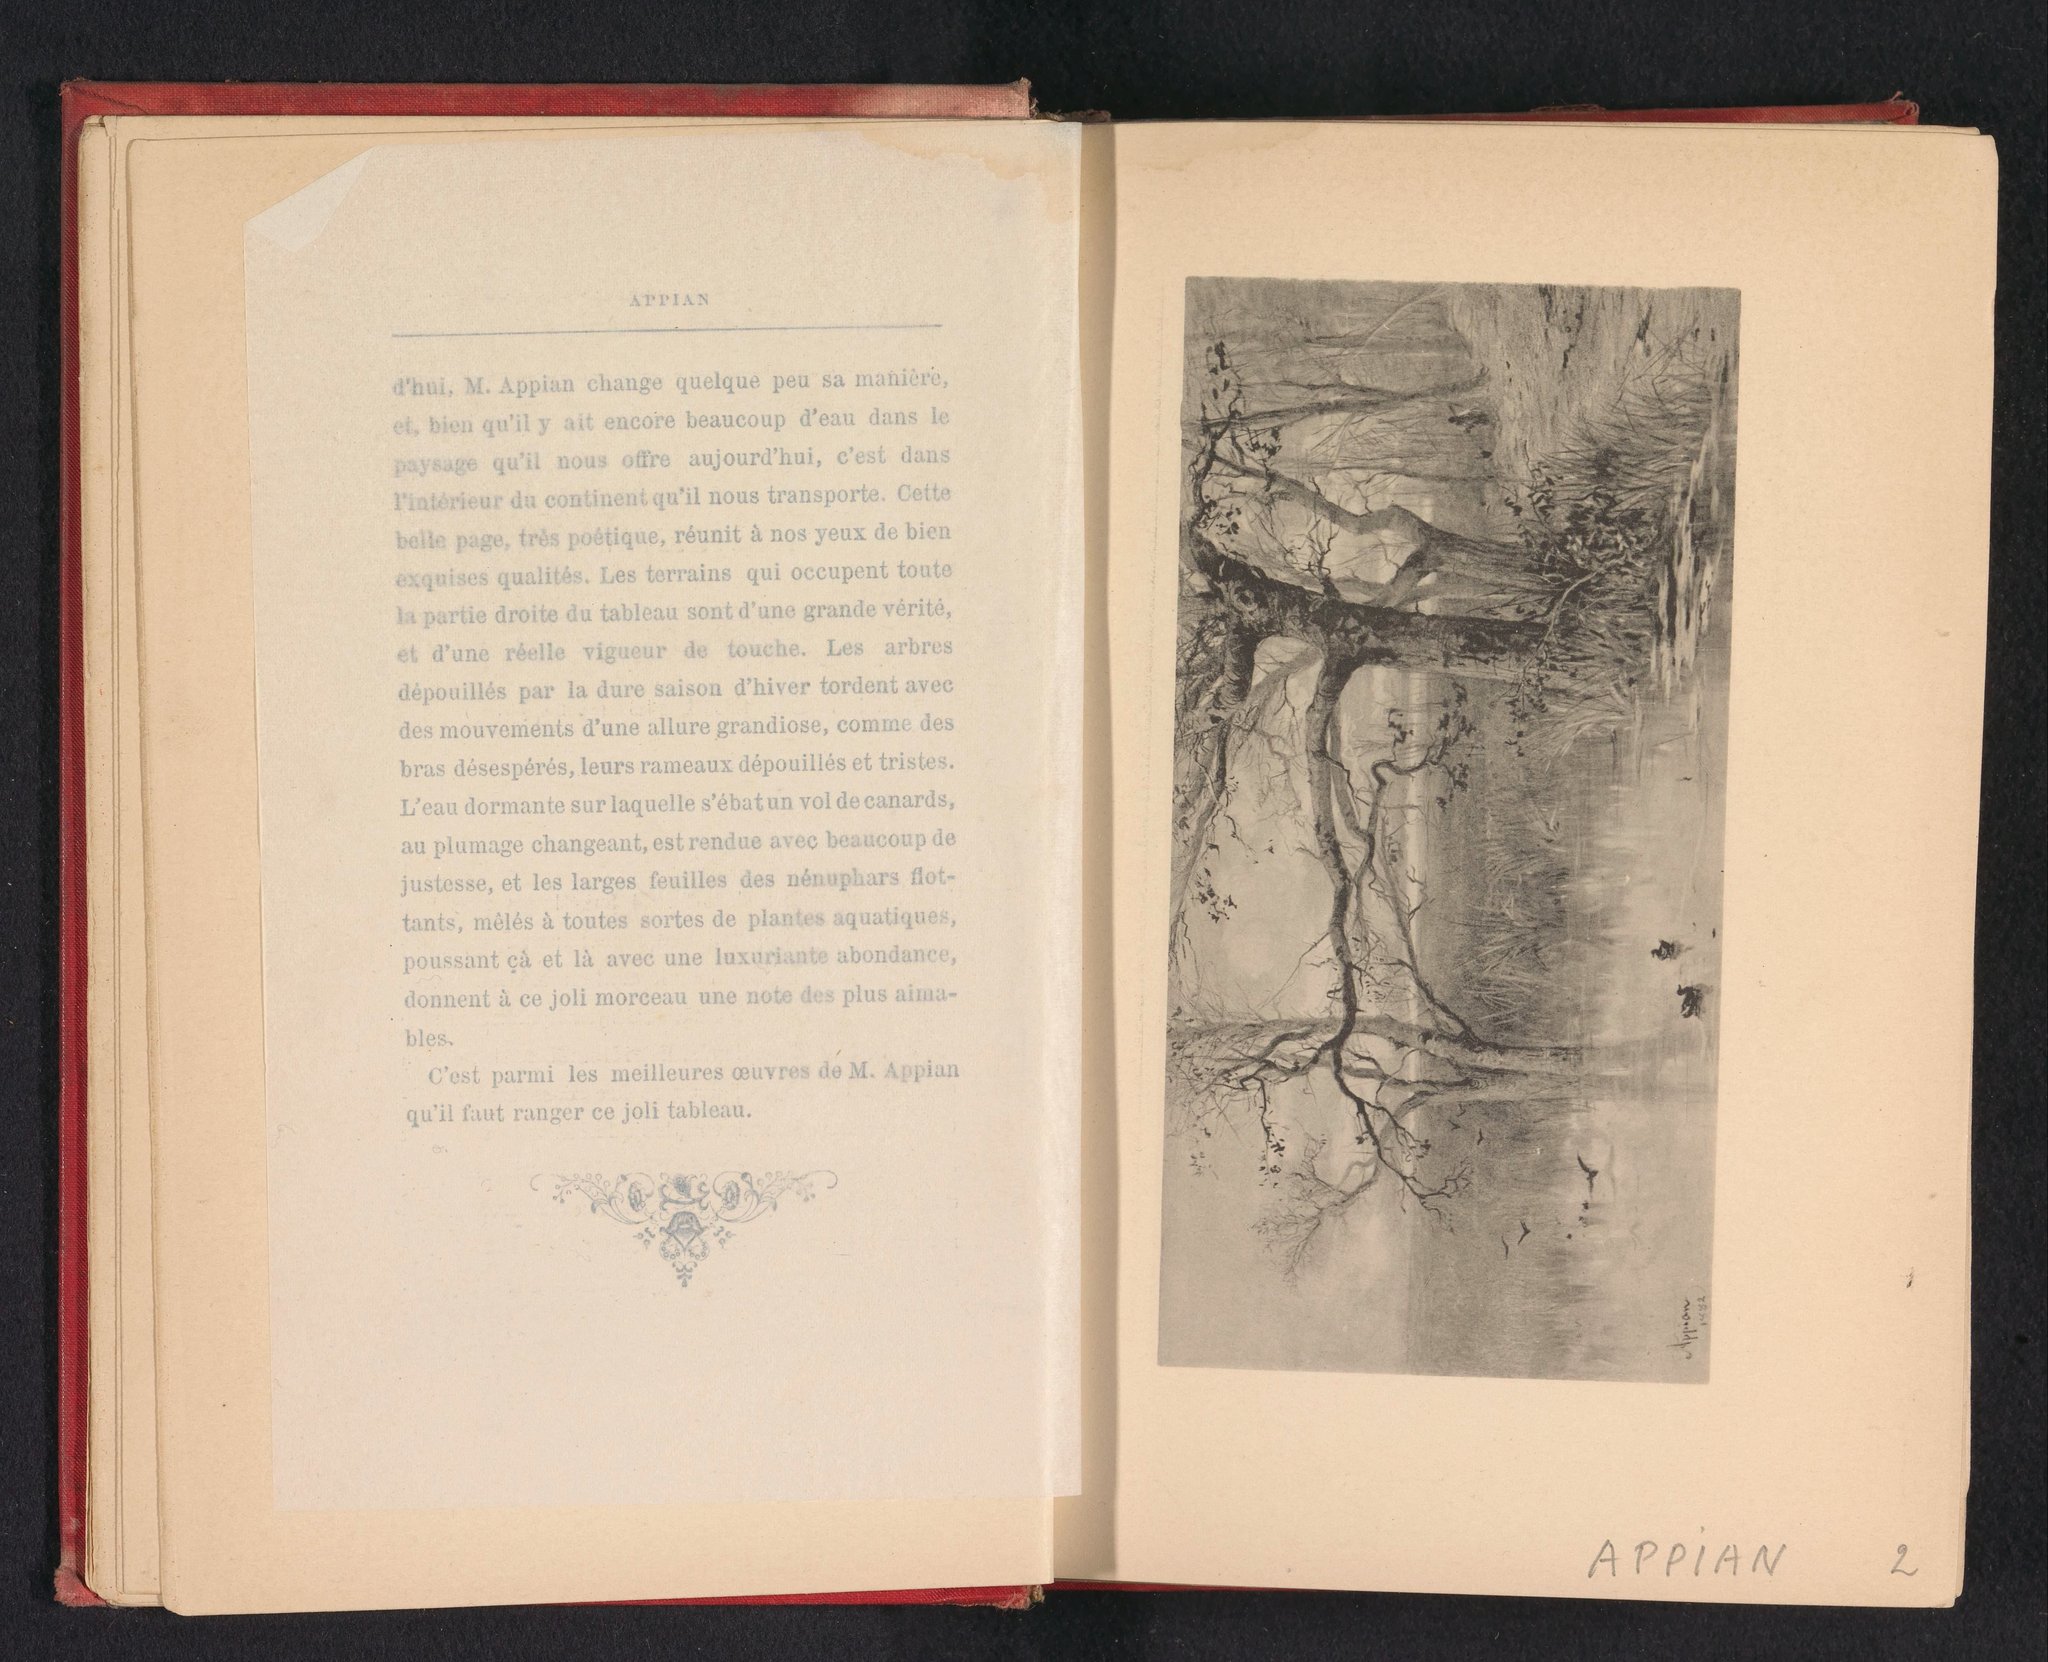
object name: page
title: Fotoreproductie van een schilderij, voorstellende een moeraslandschap met eenden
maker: jacques barthélemy appian (adolphe)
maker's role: print maker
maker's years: 1818-1898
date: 1872-1882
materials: paper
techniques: photograph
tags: swamps and polders, water-birds: duck